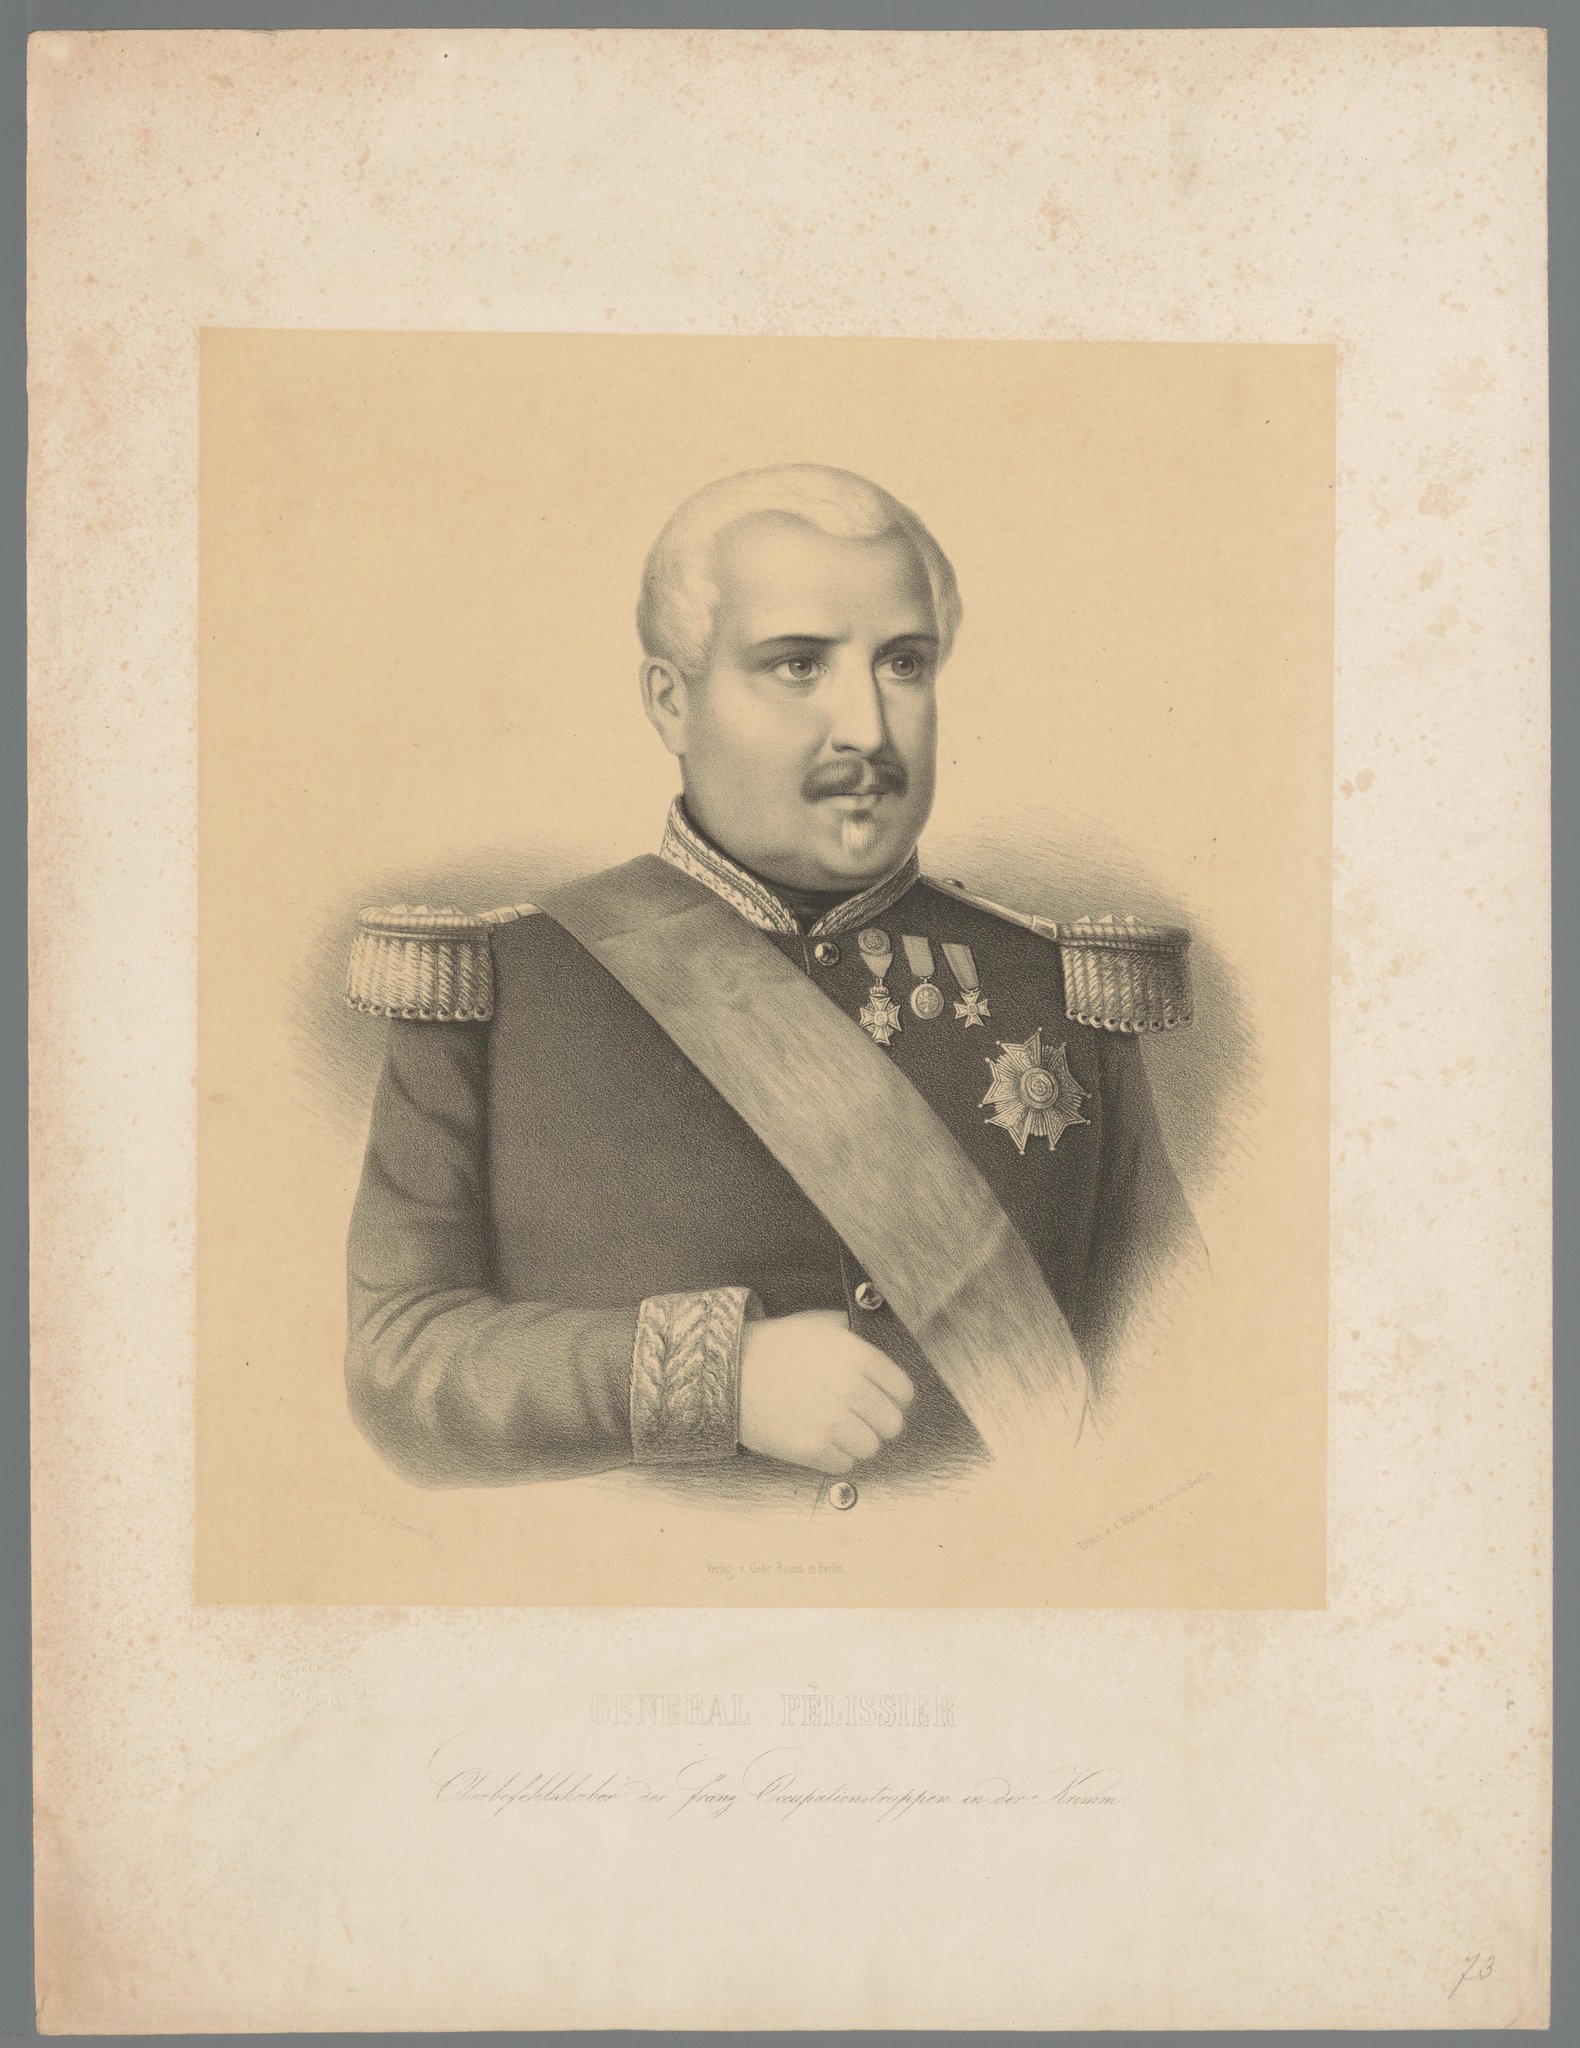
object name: print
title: Portret van Aimable Jean Jacques Pélissier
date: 1840-1875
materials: paper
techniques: tone lithography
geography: berlin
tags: adult man, historical persons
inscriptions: collector's mark: Lugt 2228, check stamp: Lugt 2141c